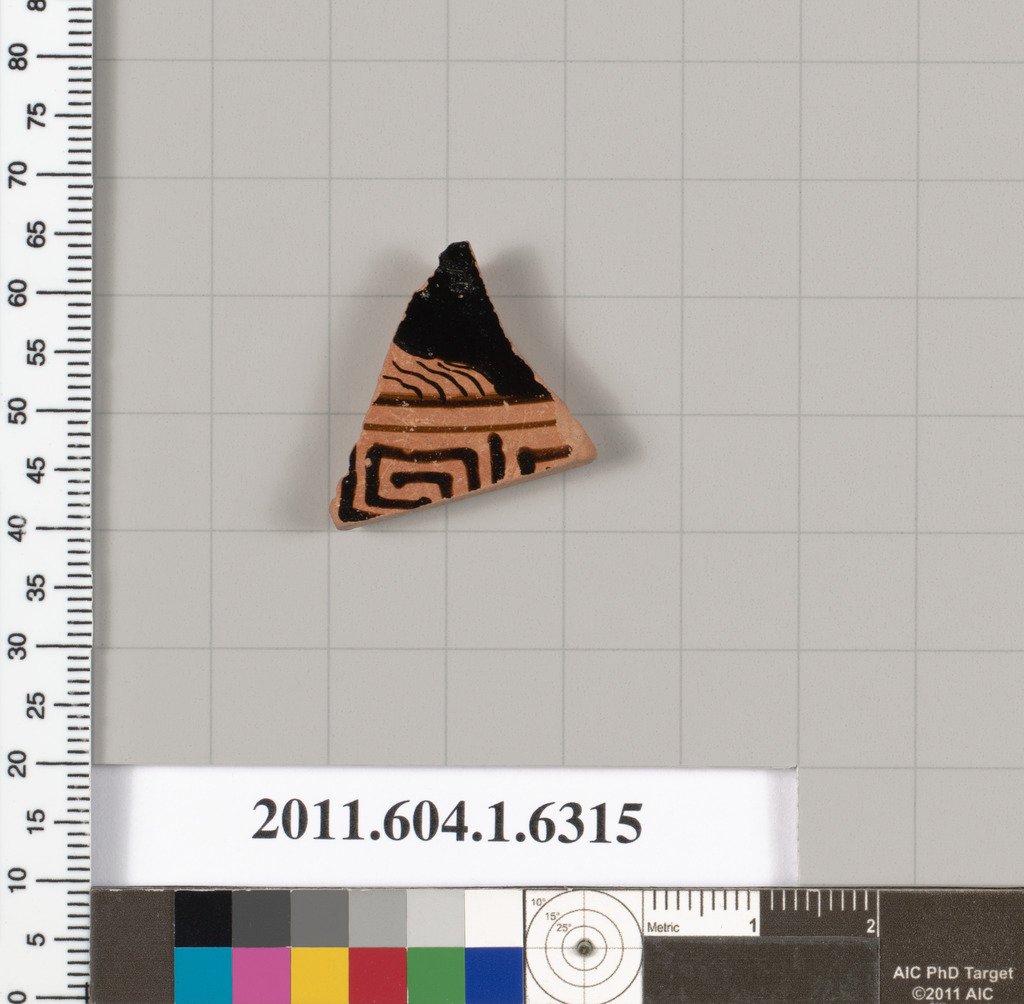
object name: kylix fragment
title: Terracotta fragment of a kylix (drinking cup)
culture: greek, attic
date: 500-480 BCE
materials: terracotta